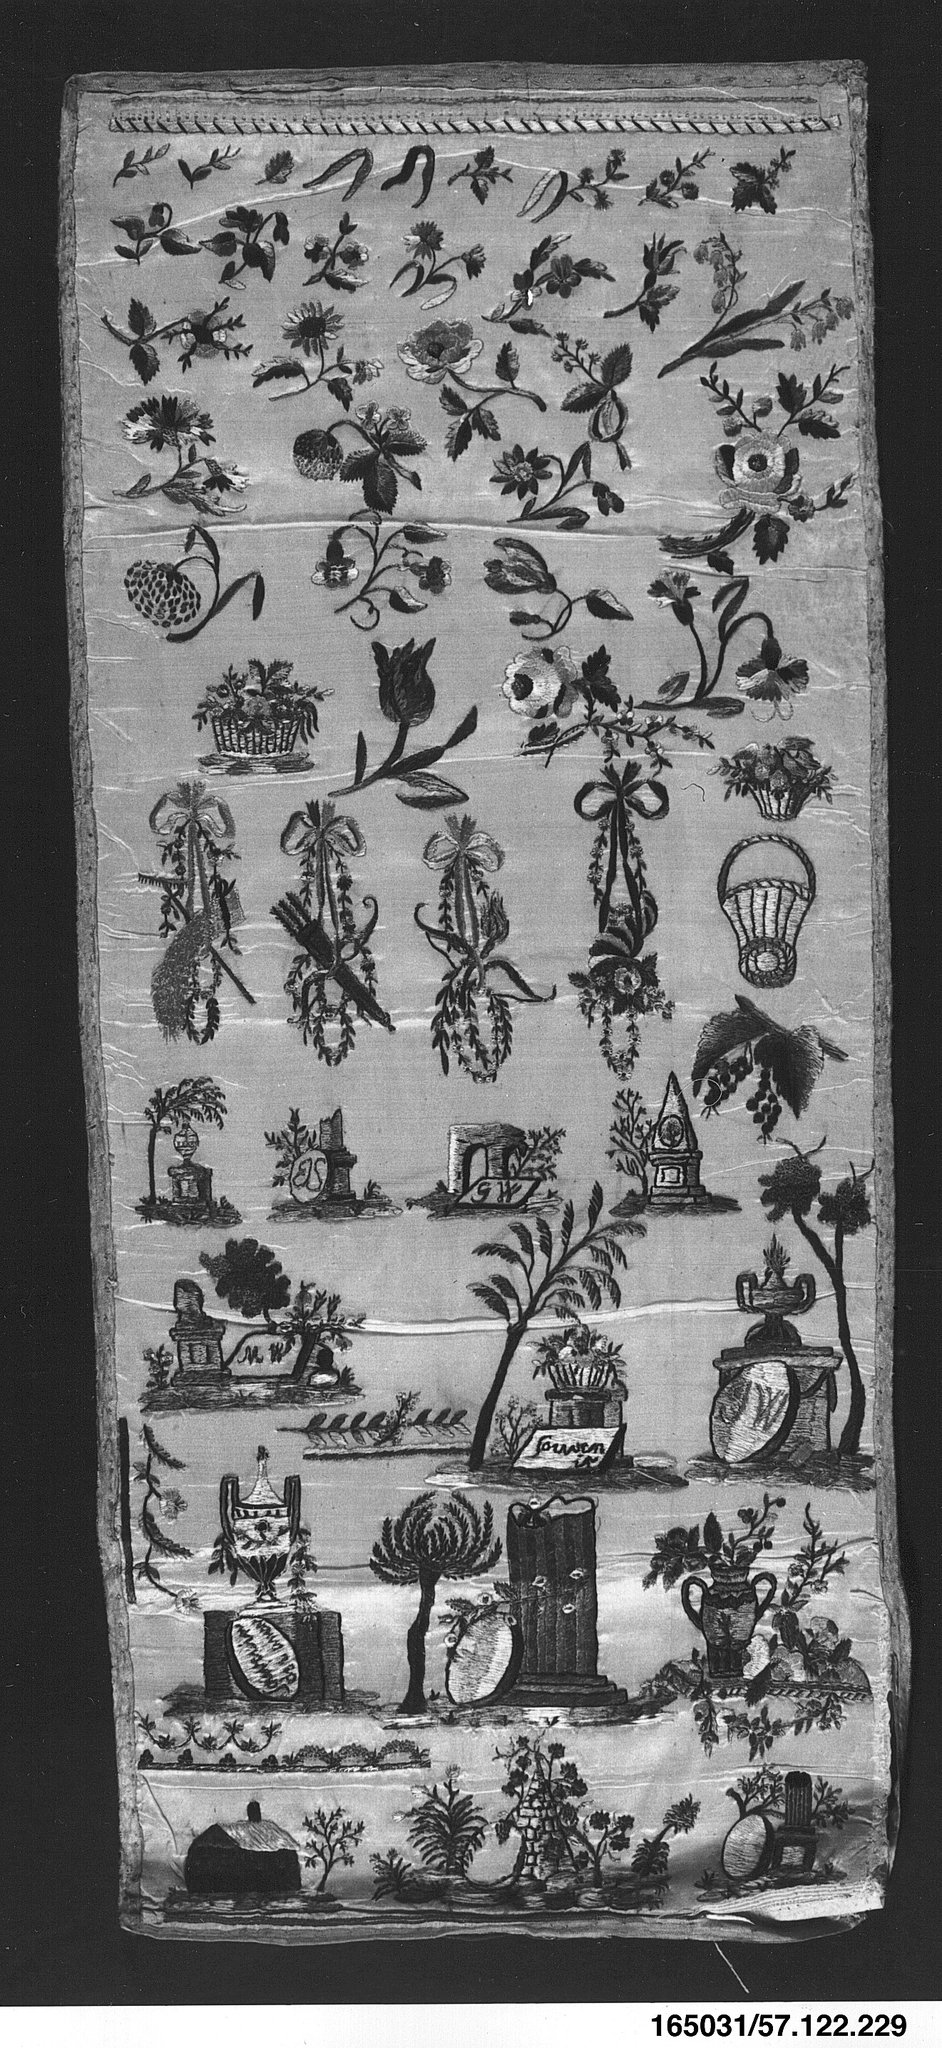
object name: sampler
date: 1801-1900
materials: silk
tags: flowers,trees